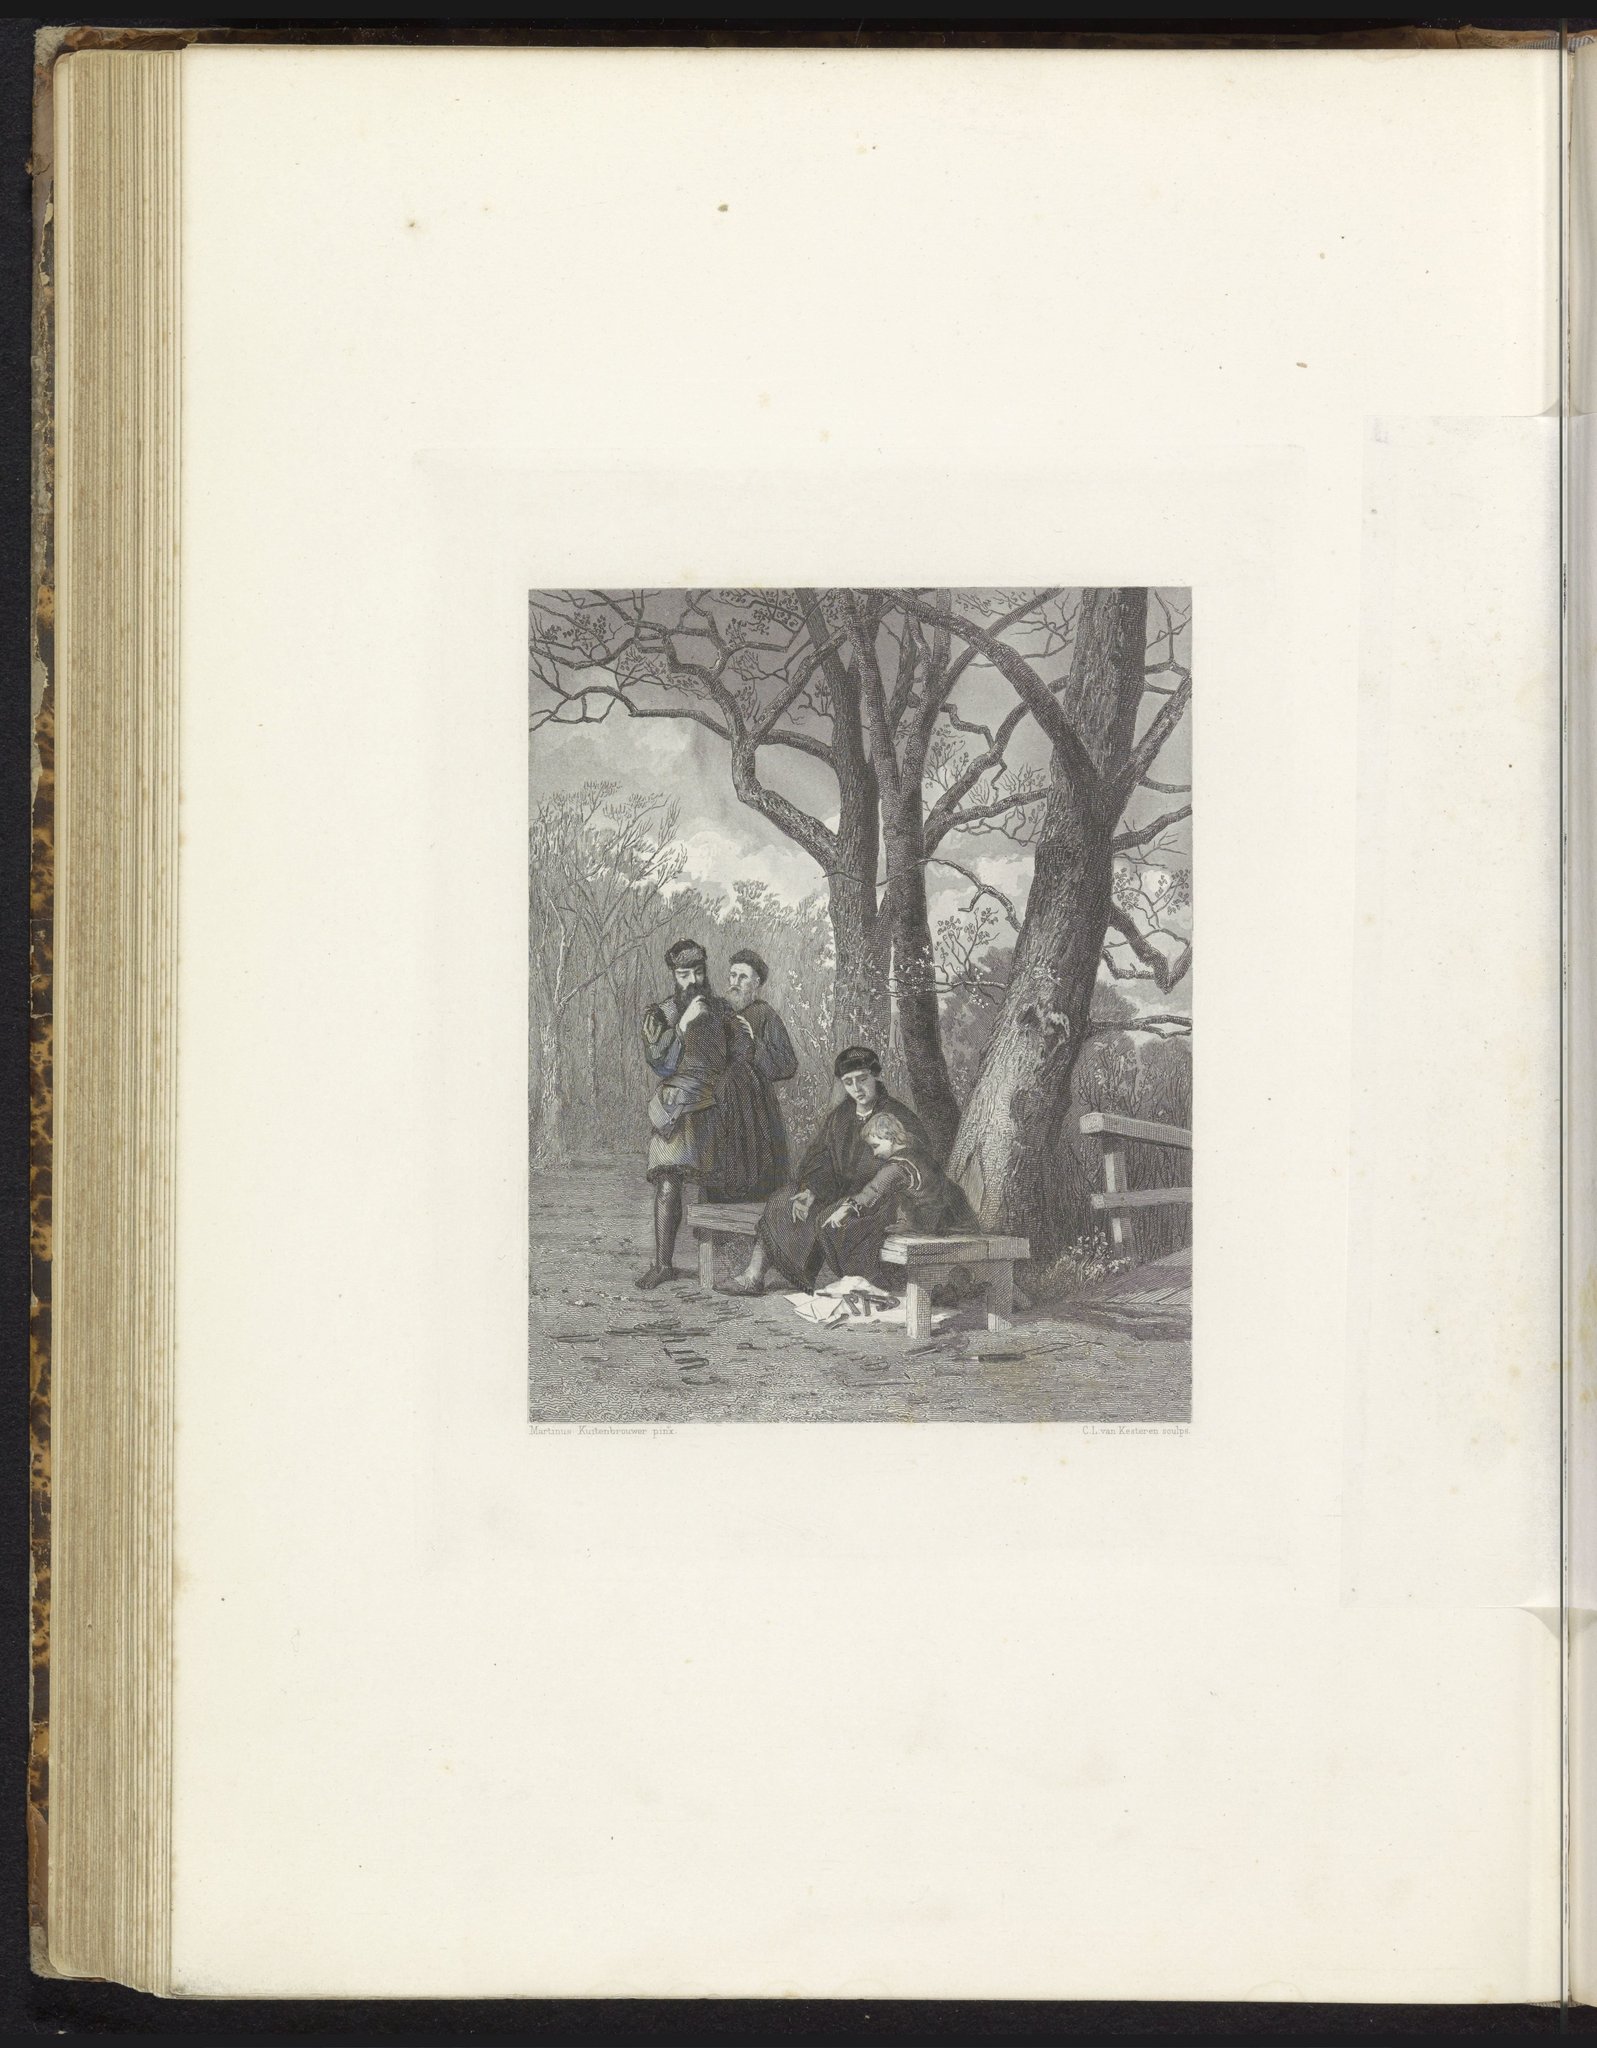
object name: history print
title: Laurens Janszoon Koster in den Haarlemmerhout, 1420 à 1425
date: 1865-1870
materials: paper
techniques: engraving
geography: netherlands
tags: haarlem, invention, discovery ~ science and technology, burgundian netherlands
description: Laurens Jansz. Coster spelend met een kind in de Haarlemmerhout vindt de boekdrukkunst uit, 1420-1425. Onderdeel van de groep staalgravures naar de schilderijen van de Historische Galerij der Maatschappij Arti et Amicitiae.